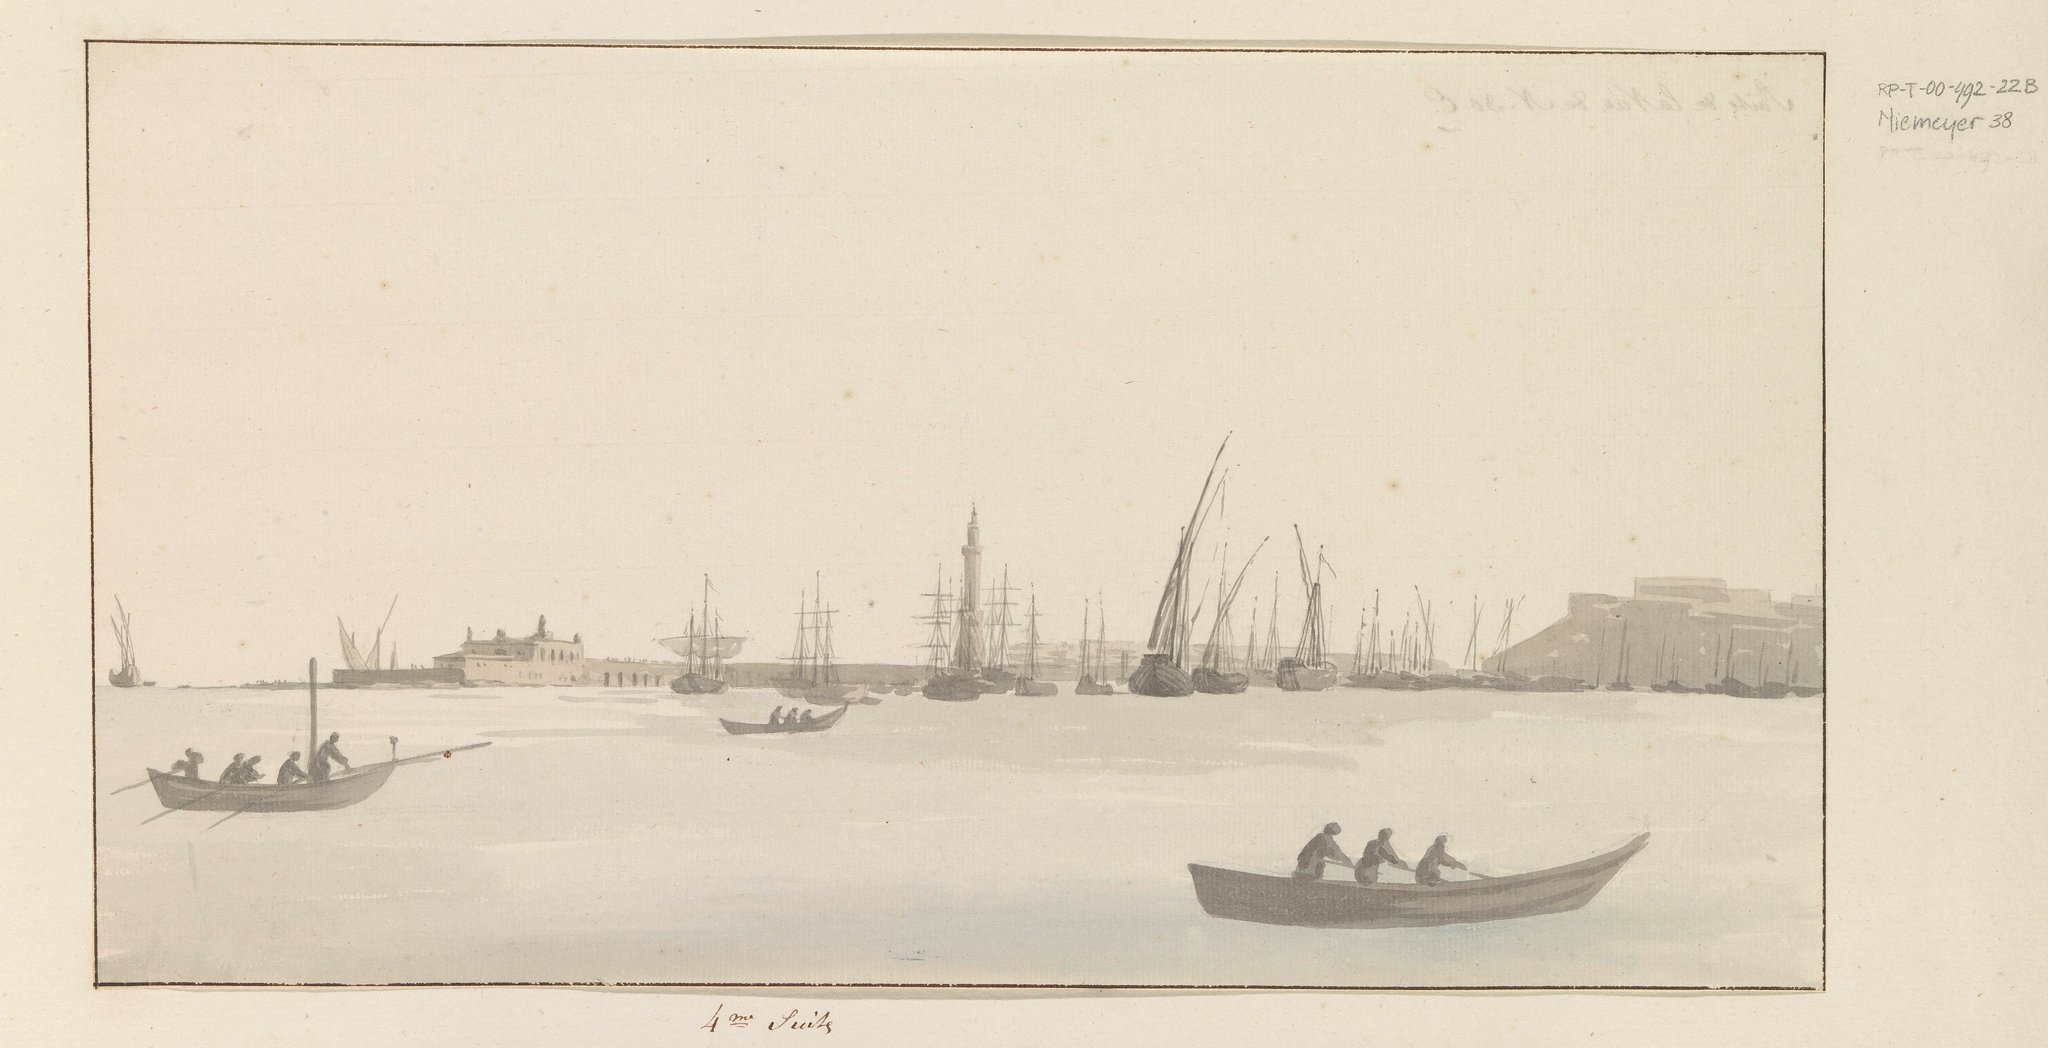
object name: drawing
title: Voyage en Italie, en Sicile et à Malte - 1778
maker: louis ducros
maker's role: draughtsman, print maker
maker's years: 1748-1810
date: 1778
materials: chalk, paper, watercolor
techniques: brush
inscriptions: number: ‘Suite de la vue de No. 30E’